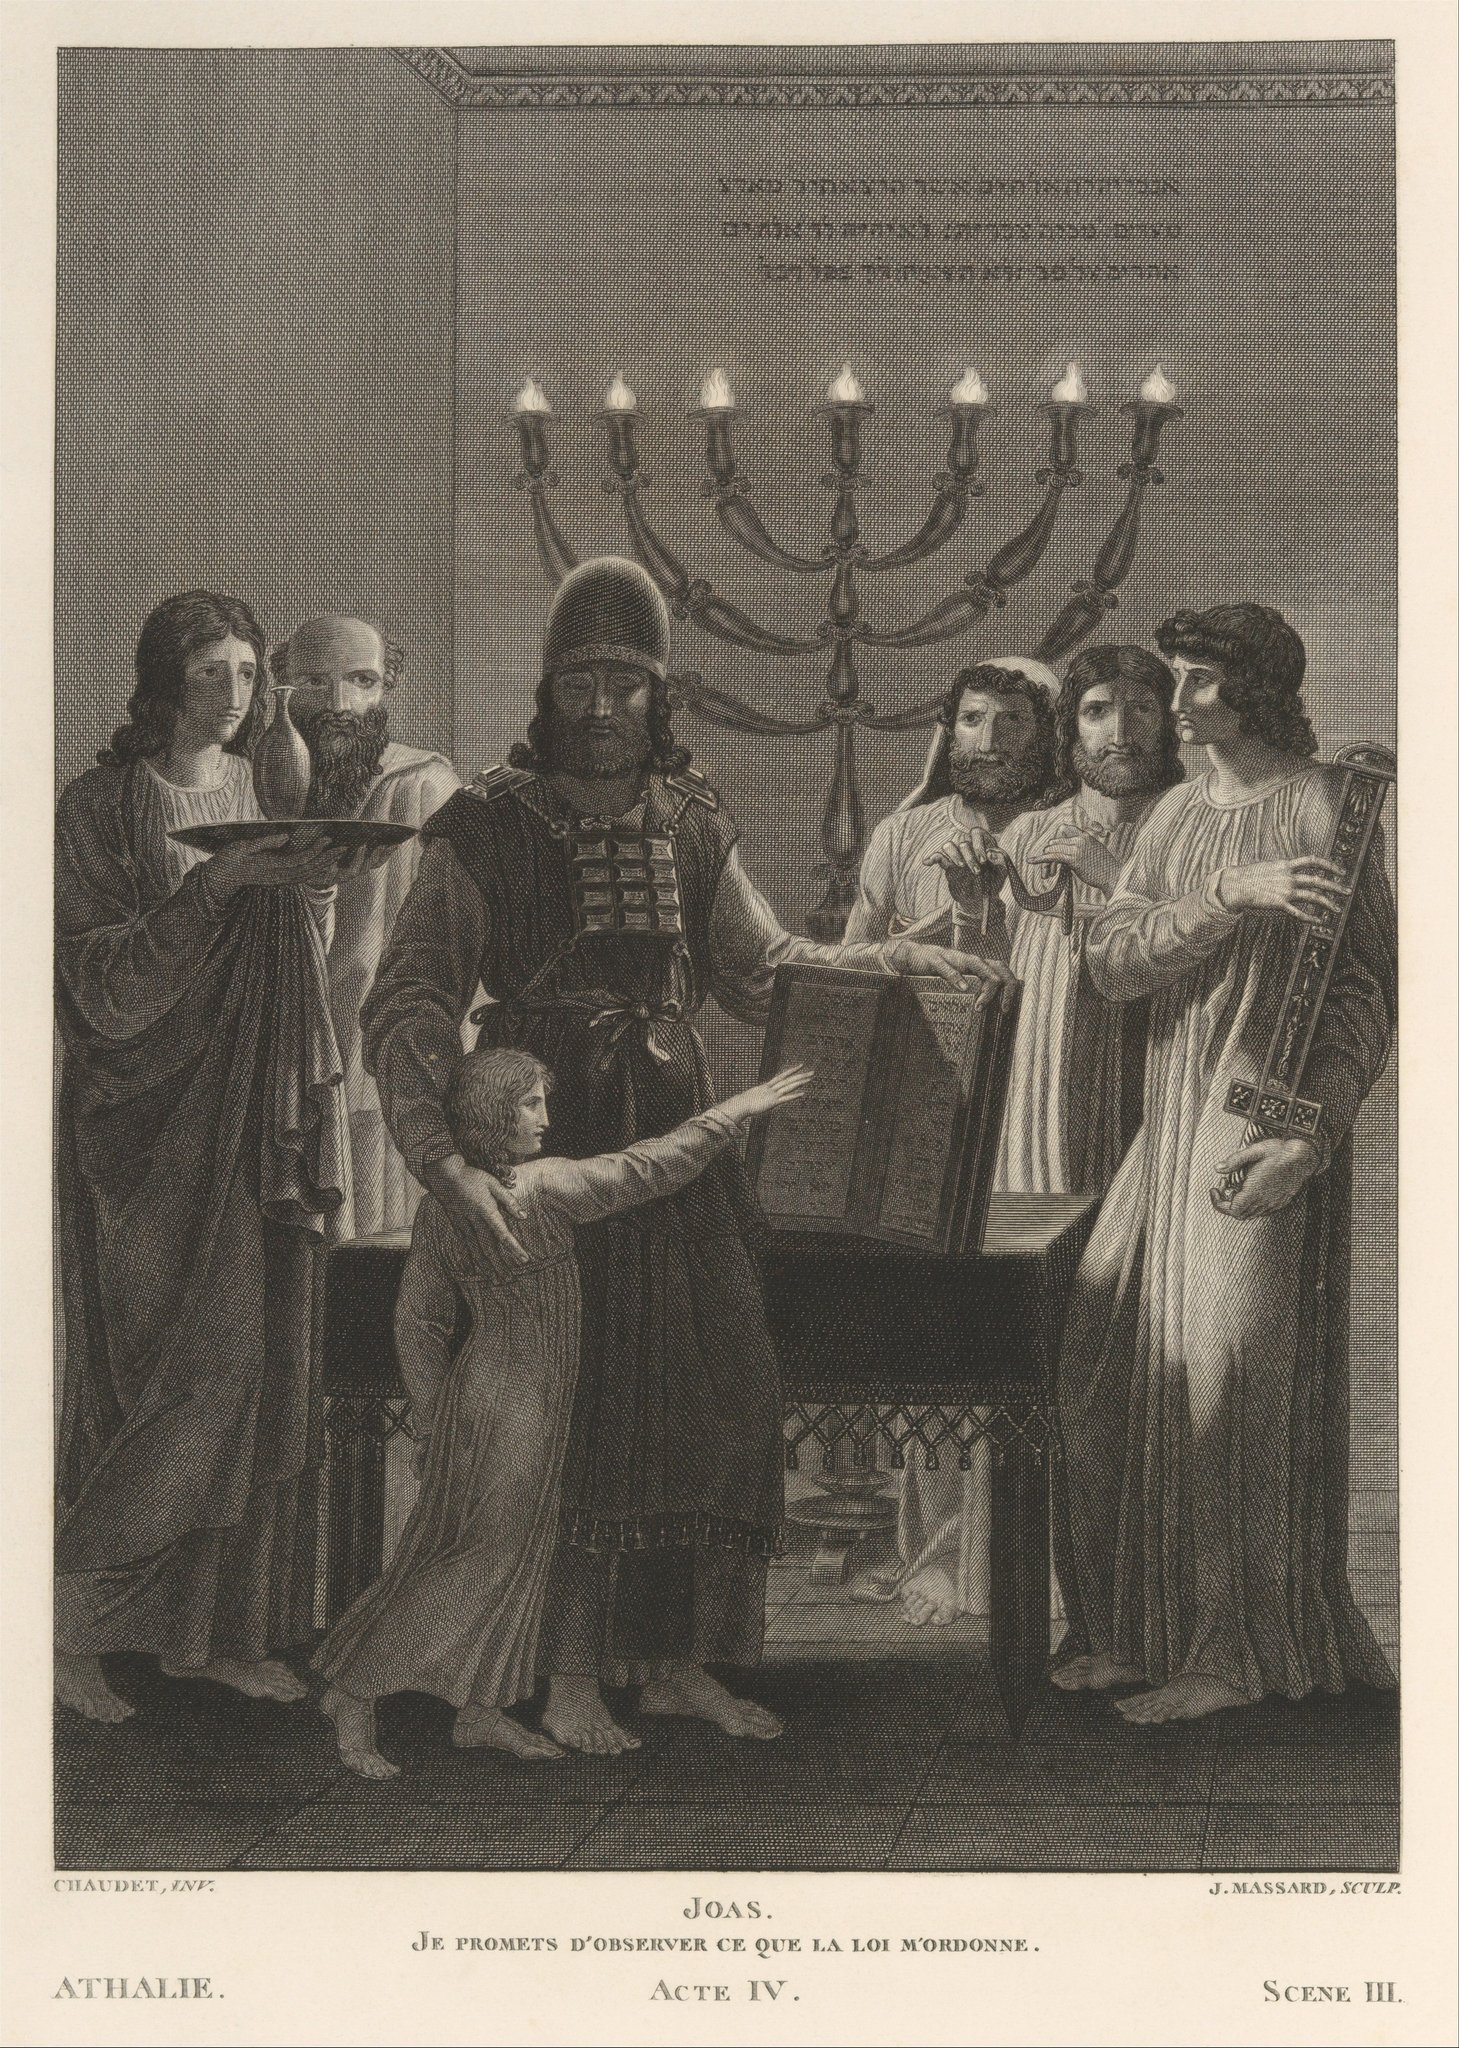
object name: book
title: Oeuvres de Jean Racine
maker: jean racine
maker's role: author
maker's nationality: french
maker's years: 1639-1699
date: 1801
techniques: engraving, printing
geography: france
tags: girls,men,menorah